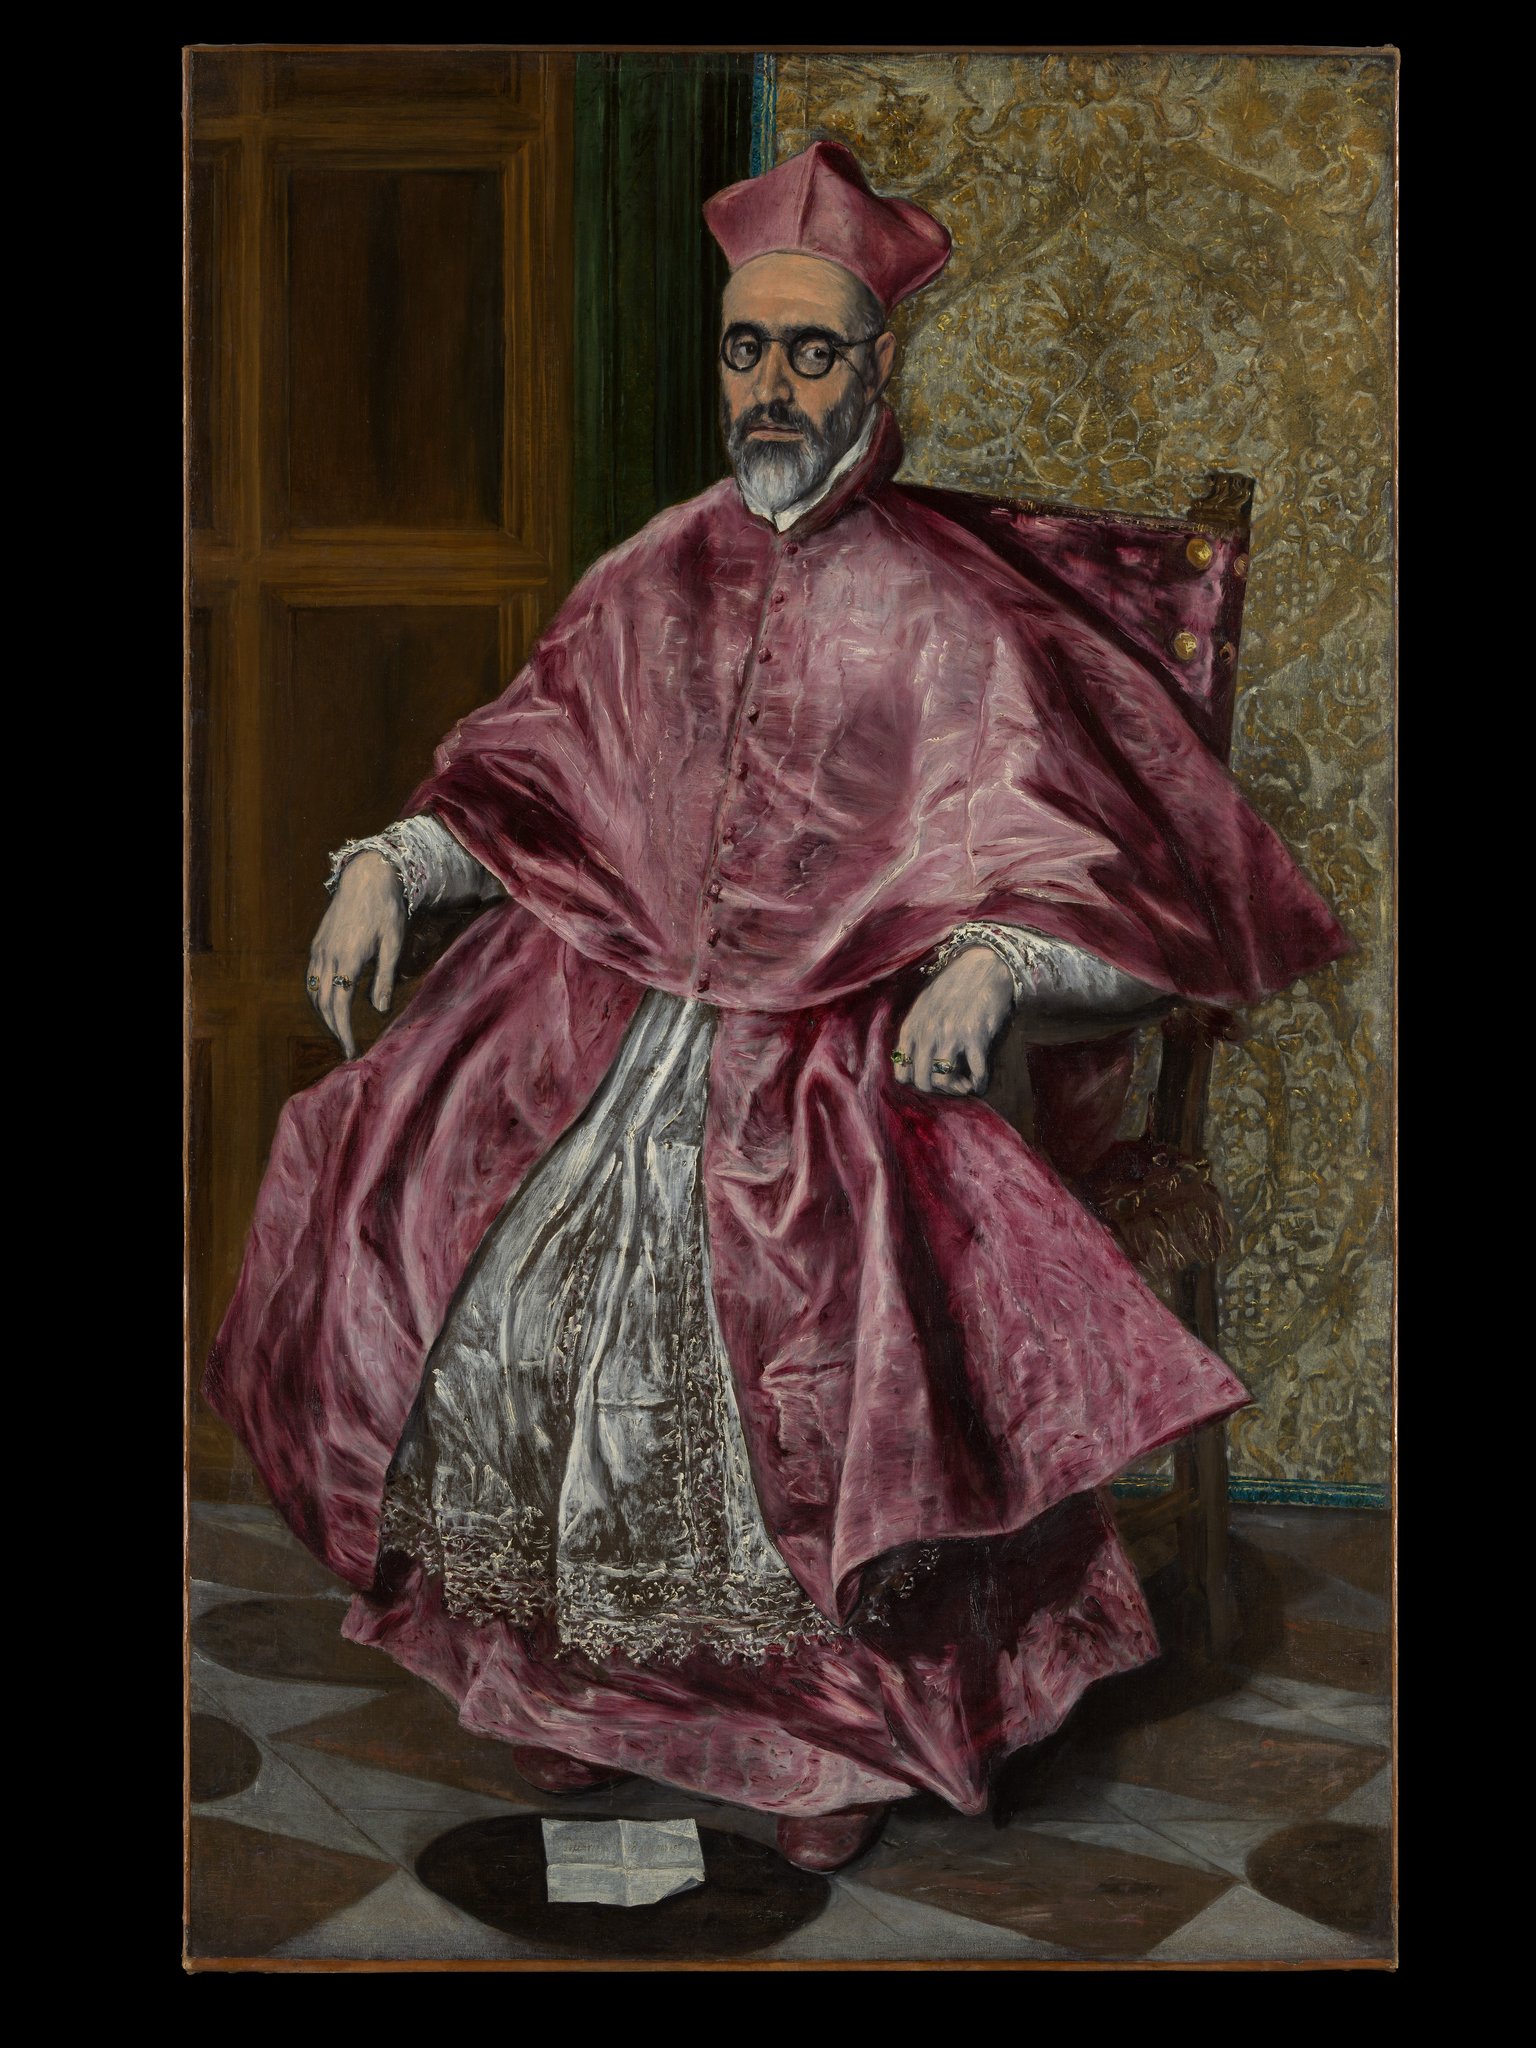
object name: painting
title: Cardinal Fernando Niño de Guevara (1541–1609)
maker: el greco (domenikos theotokopoulos)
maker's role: artist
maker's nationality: greek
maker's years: 1540-1614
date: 1600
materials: canvas, oil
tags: men,portraits